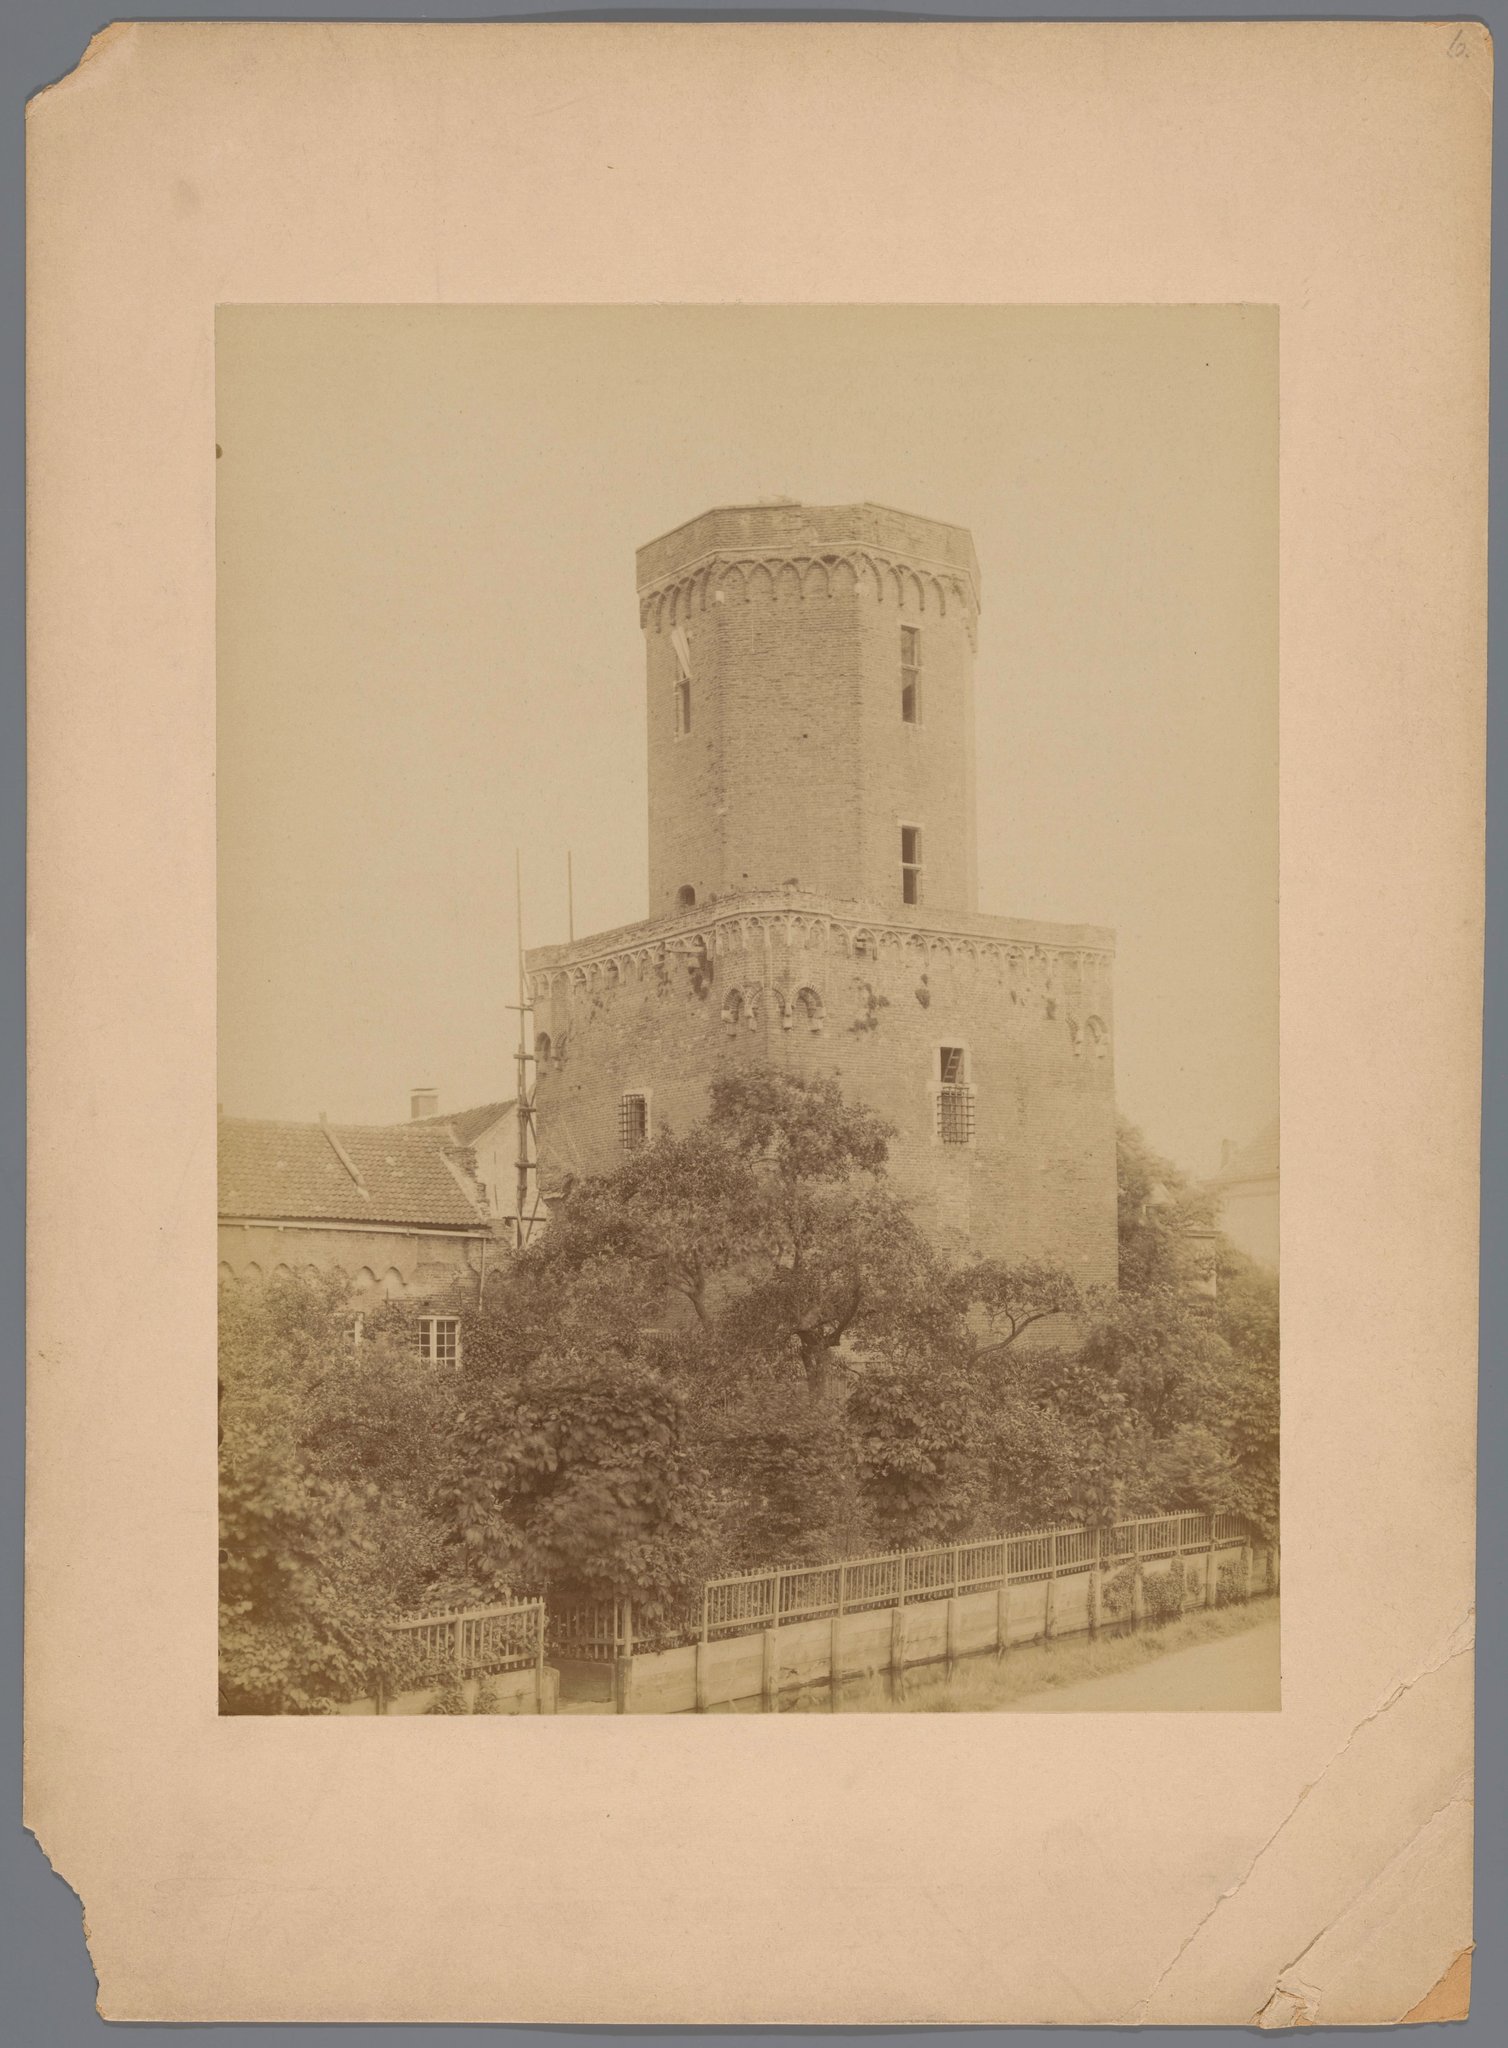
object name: photograph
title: Gezicht op de Drogenapstoren in Zutphen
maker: Anonymous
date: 1875-1900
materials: cardboard, photographic support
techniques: albumen print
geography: zutphen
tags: tower, clock tower ~ monumental adornment, façade (of house or building), city-gate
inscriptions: collector's mark: ‘RIJKS-NORMAALSCHOOL VOOR TEEKENONDERWIJZERS. AMSTERDAM’, inscription: ‘Drogenapstoren te Zutphen’